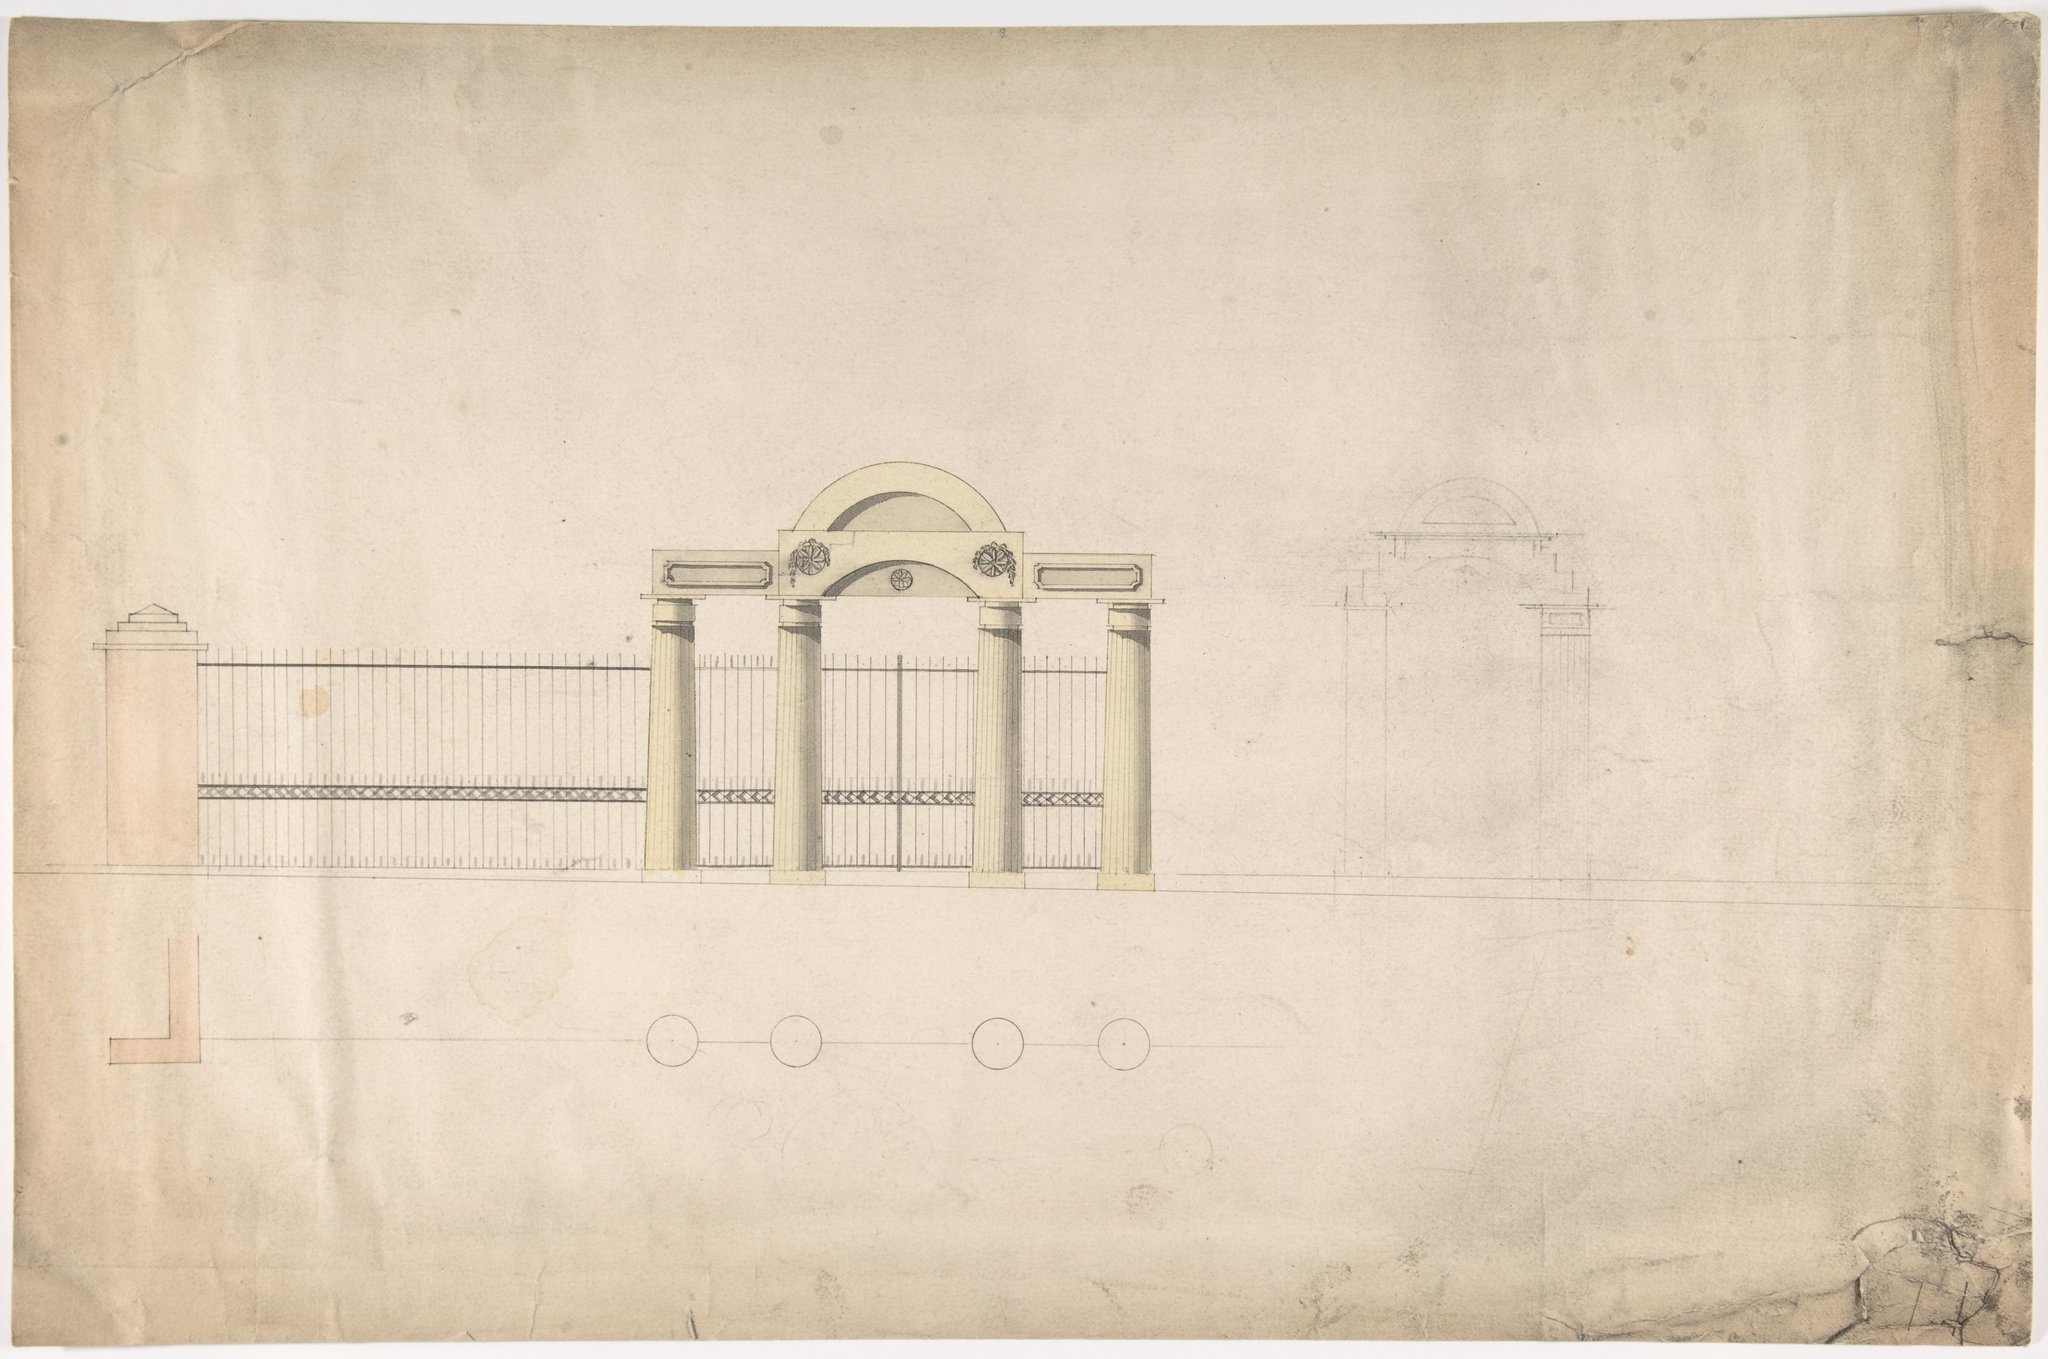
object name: drawing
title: Design for a Greek Revival Entrance Screen, Elevation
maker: anonymous, british, early 19th century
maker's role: artist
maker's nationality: british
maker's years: 1800-1850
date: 1801-1833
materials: ink, watercolor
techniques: brush, pen, wash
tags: gates